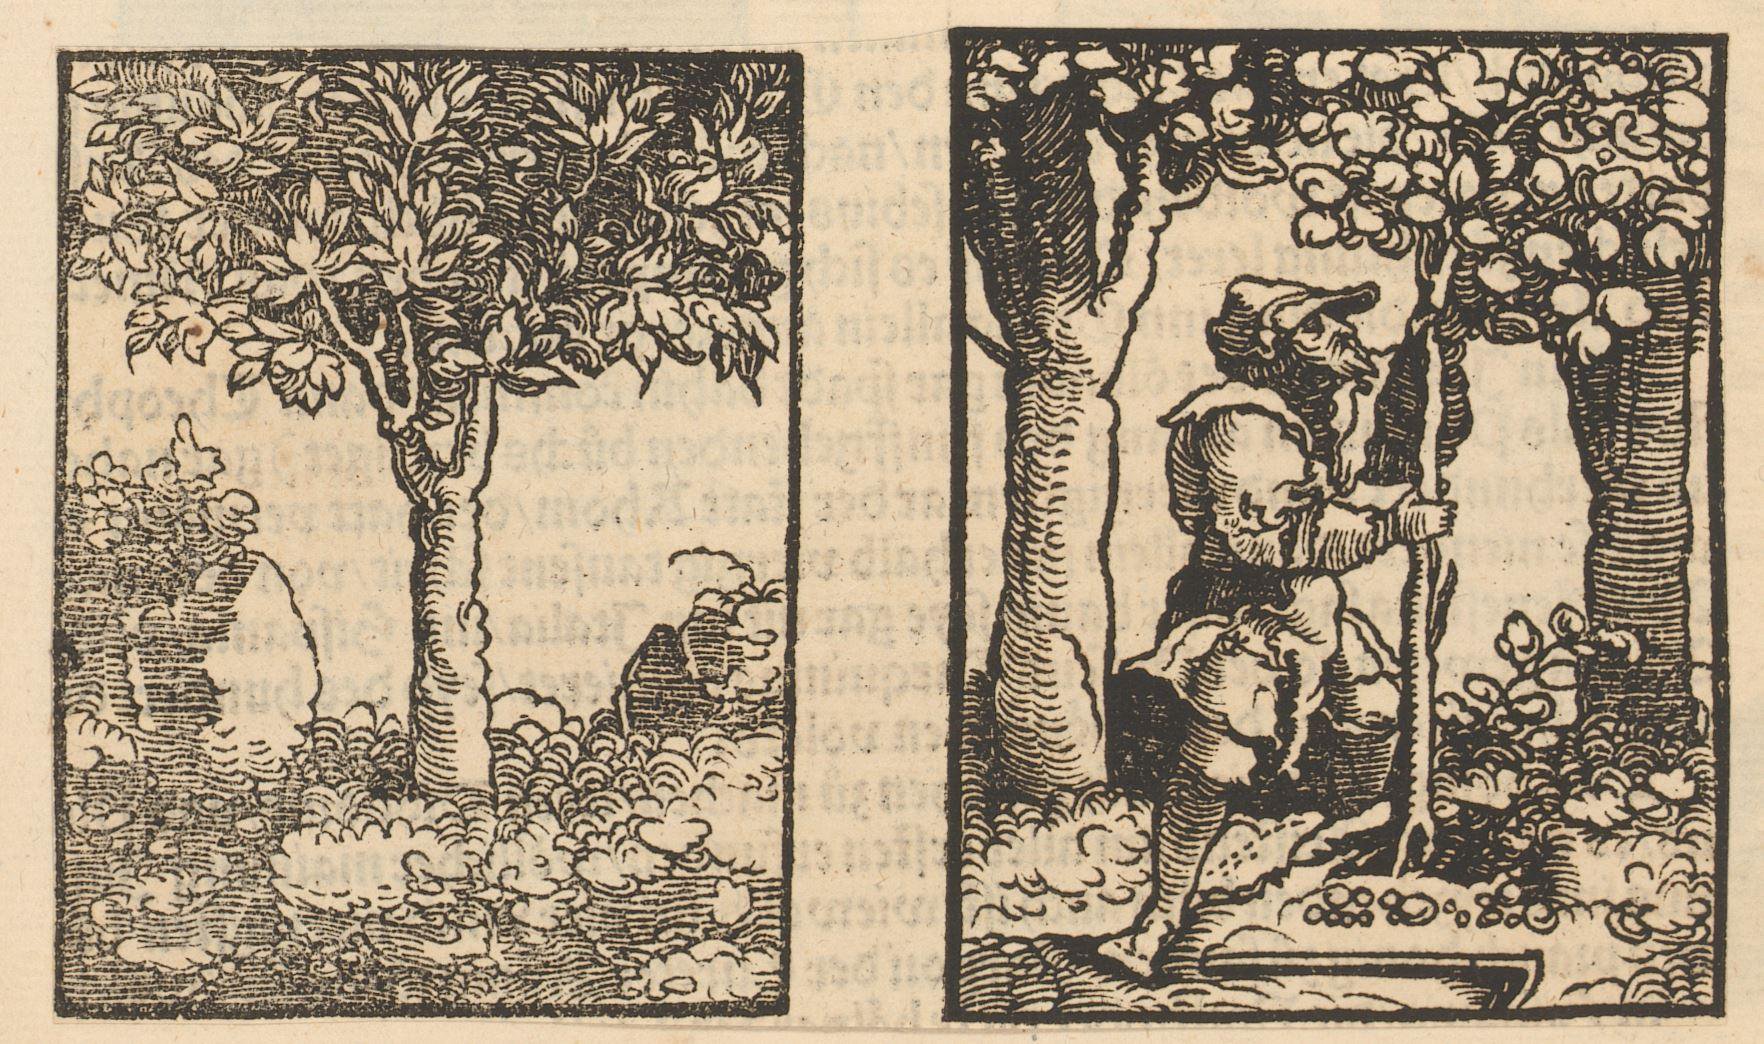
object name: album leaf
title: Boom en voorstelling van een fruitplukker tussen bomen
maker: hans schäufelein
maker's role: print maker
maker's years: 1480-1540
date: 1490-1538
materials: paper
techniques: letterpress printing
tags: trees